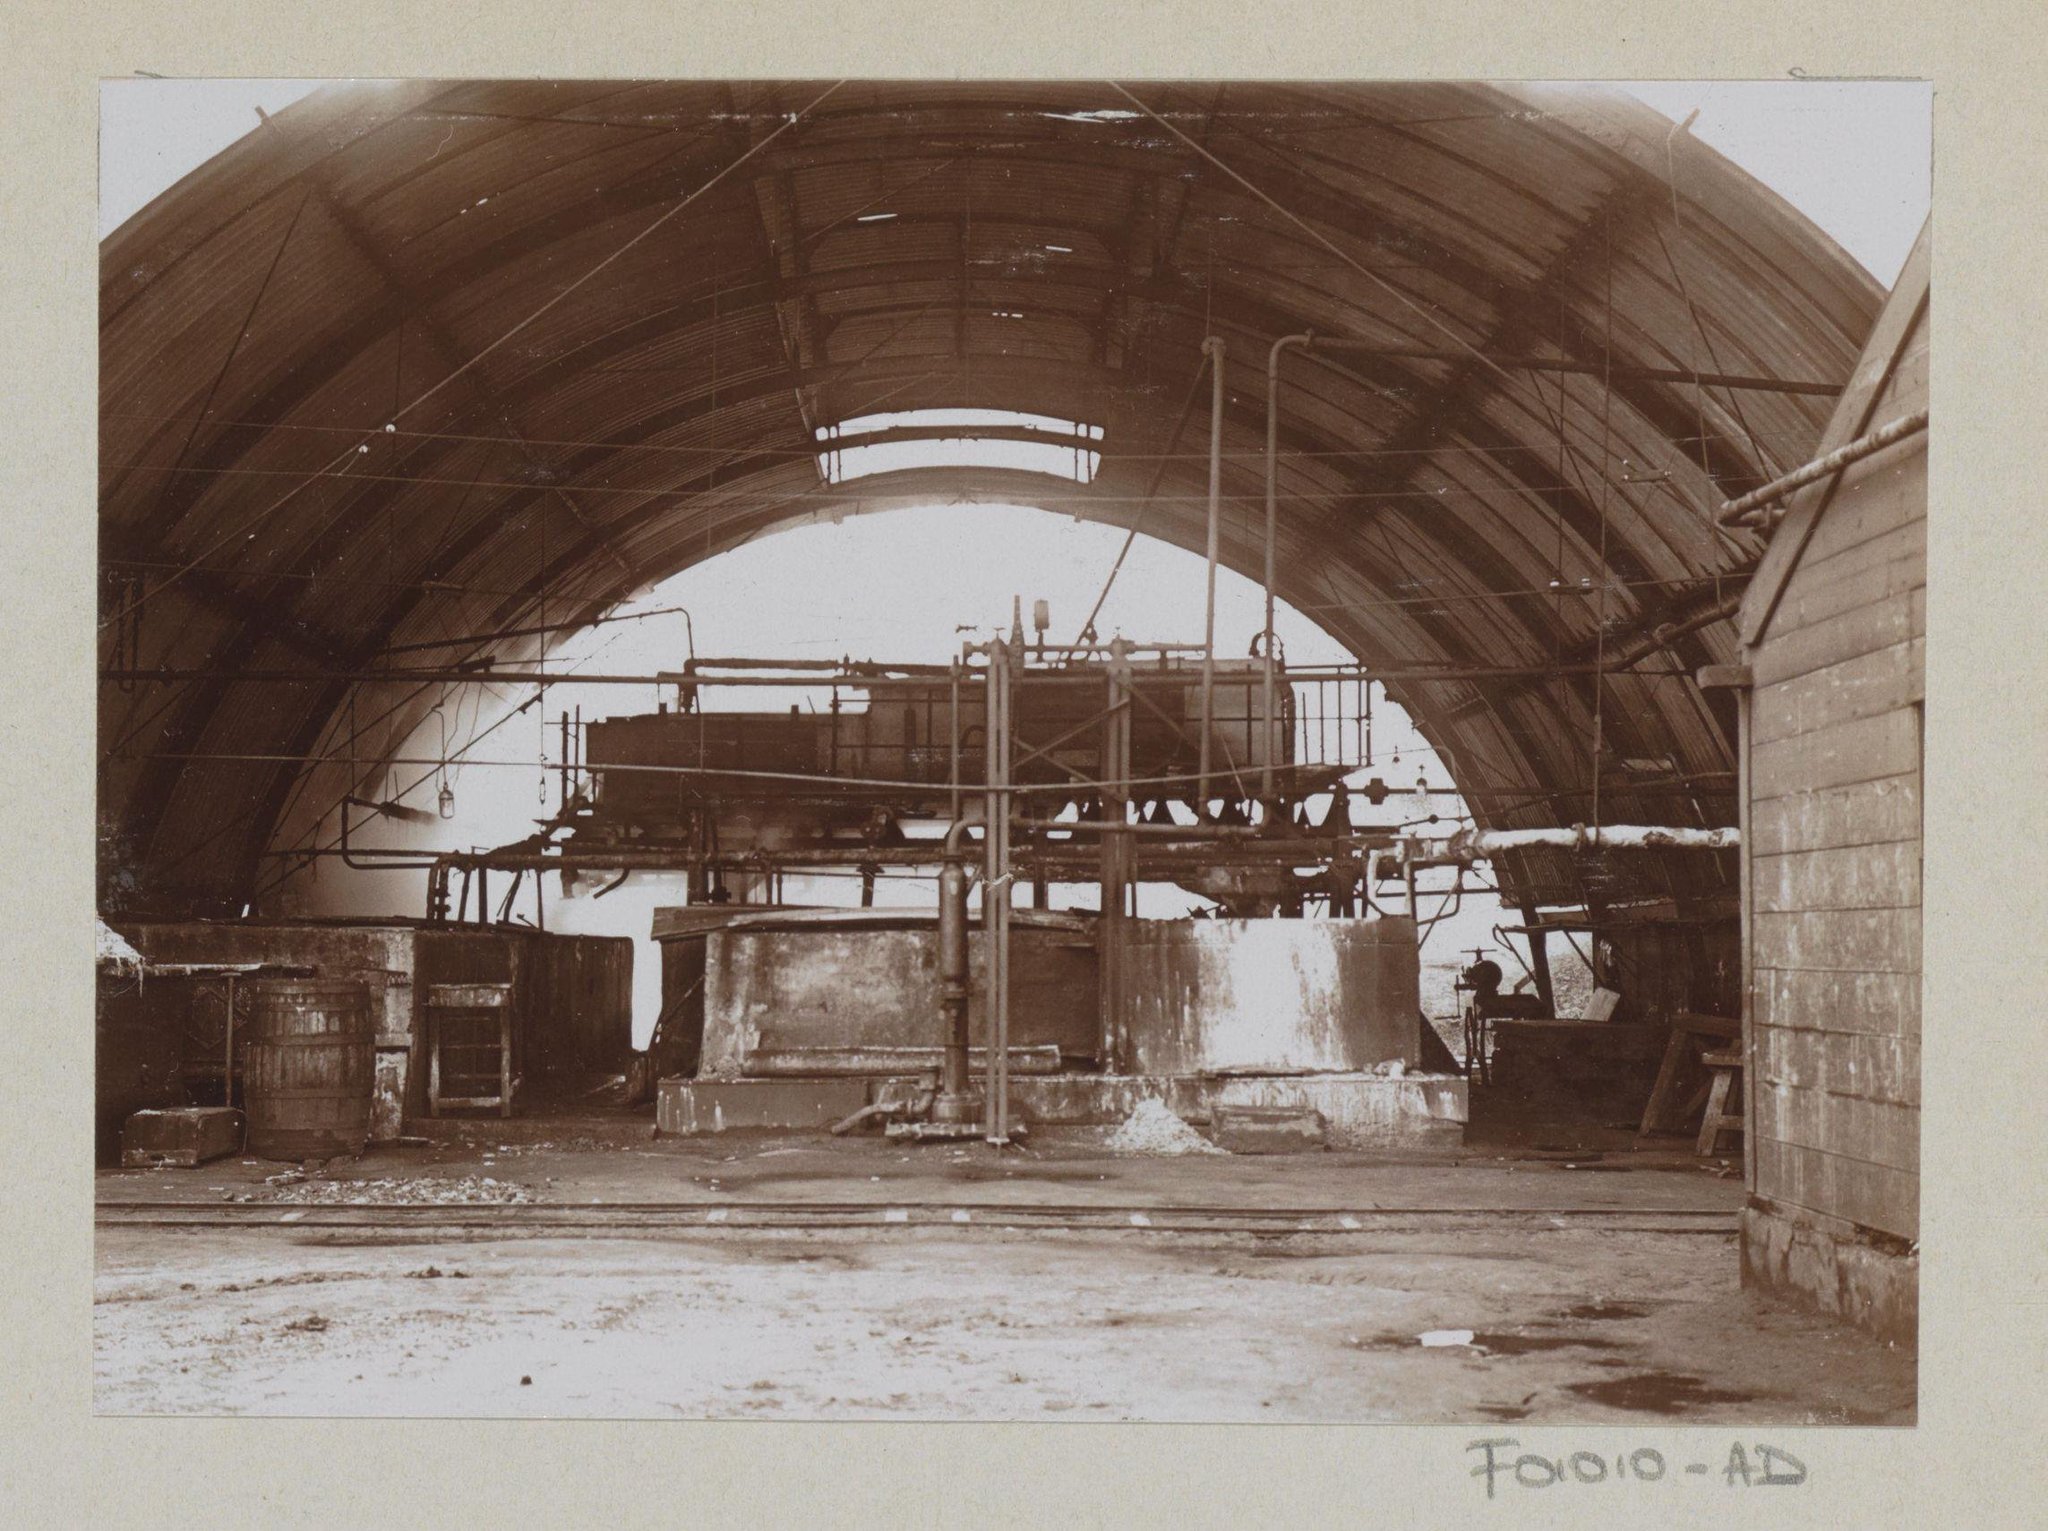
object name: photograph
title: Interieur van een halfronde fabriekshal met een machine en leidingen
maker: Anonymous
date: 1900-1910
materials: photographic support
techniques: collodion silver print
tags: factory-interior, machine shop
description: Onderdeel van Familiealbum met onder meer foto's van Wijnhandel Kraaij & Co. Bordeaux-Amsterdam.